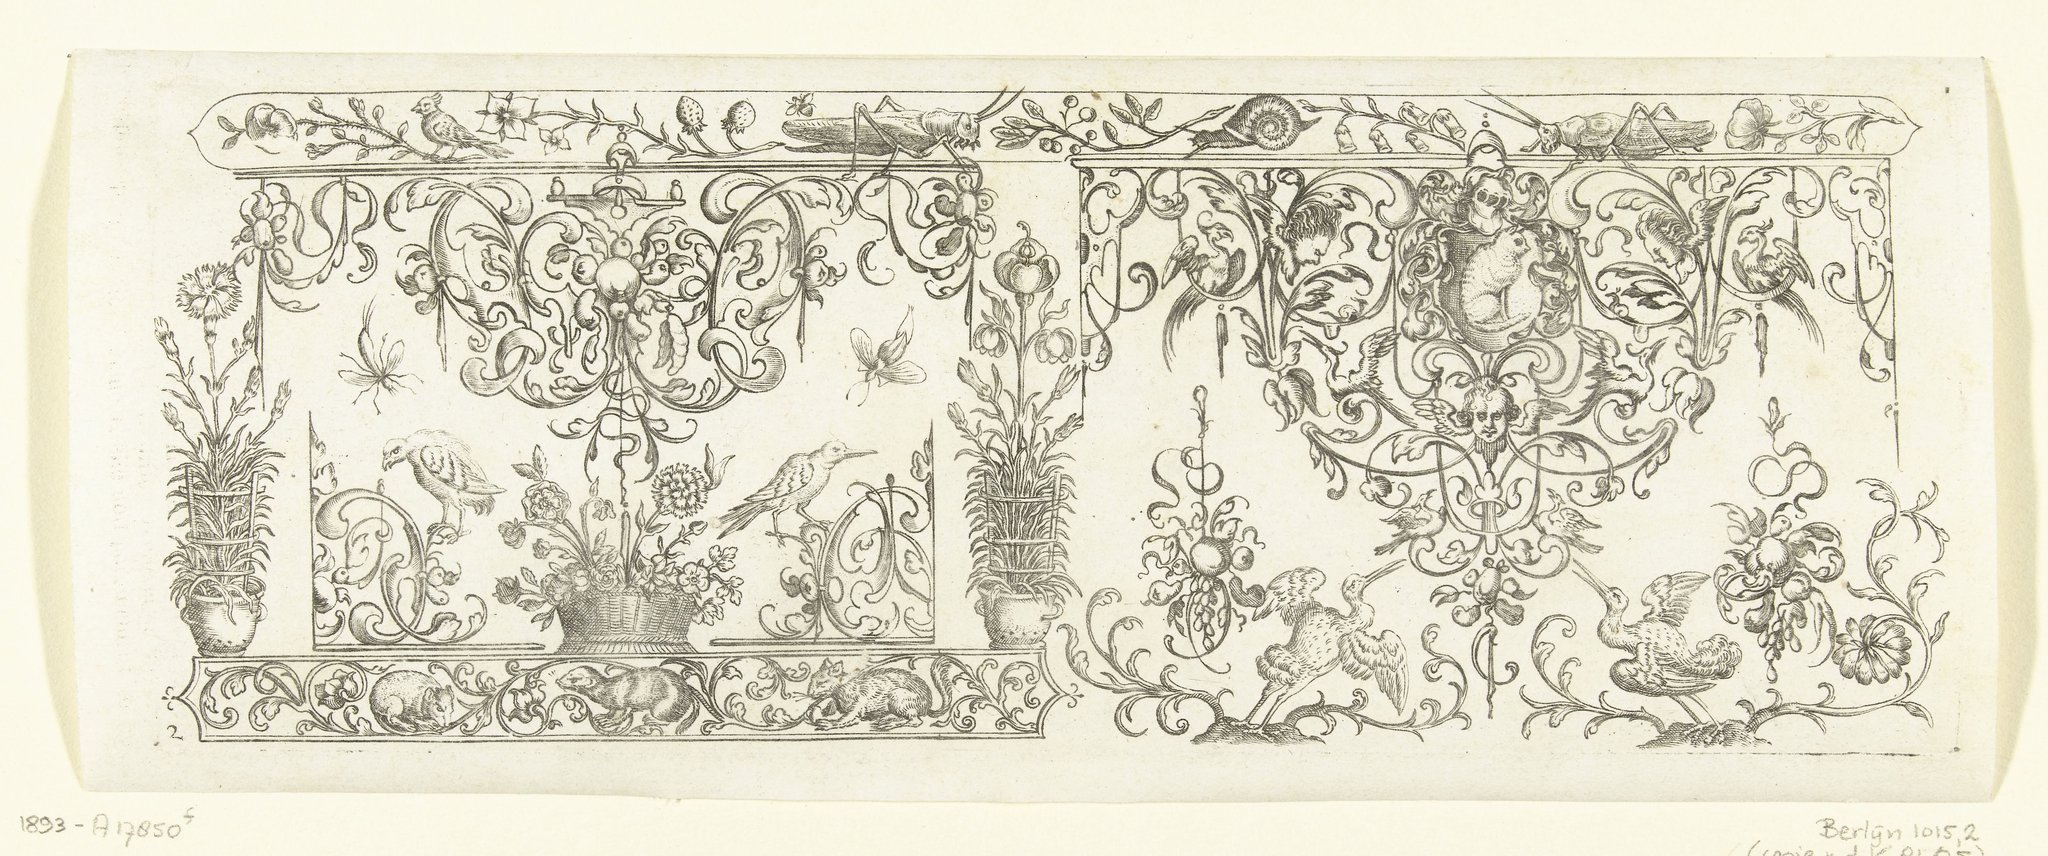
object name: print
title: Randdecoratie met bovenaan twee krekels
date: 1611-1656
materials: paper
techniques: engraving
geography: france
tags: foliage ~ ornament, insects: cricket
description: Tegenzijdige kopie naar prenten (blad 10 en 4) uit de serie Somige Eenvoldige Vruchten en Spitsen. Links staat midden onder een mand met bloemen tussen twee vogels, rechtsboven is een kat afgebeeld. Uit serie bladen waarop telkens twee motieven naast elkaar te zien zijn, aangevuld met vogels, insecten, bloempotten en soms een ornamentele rand met ranken en dieren.